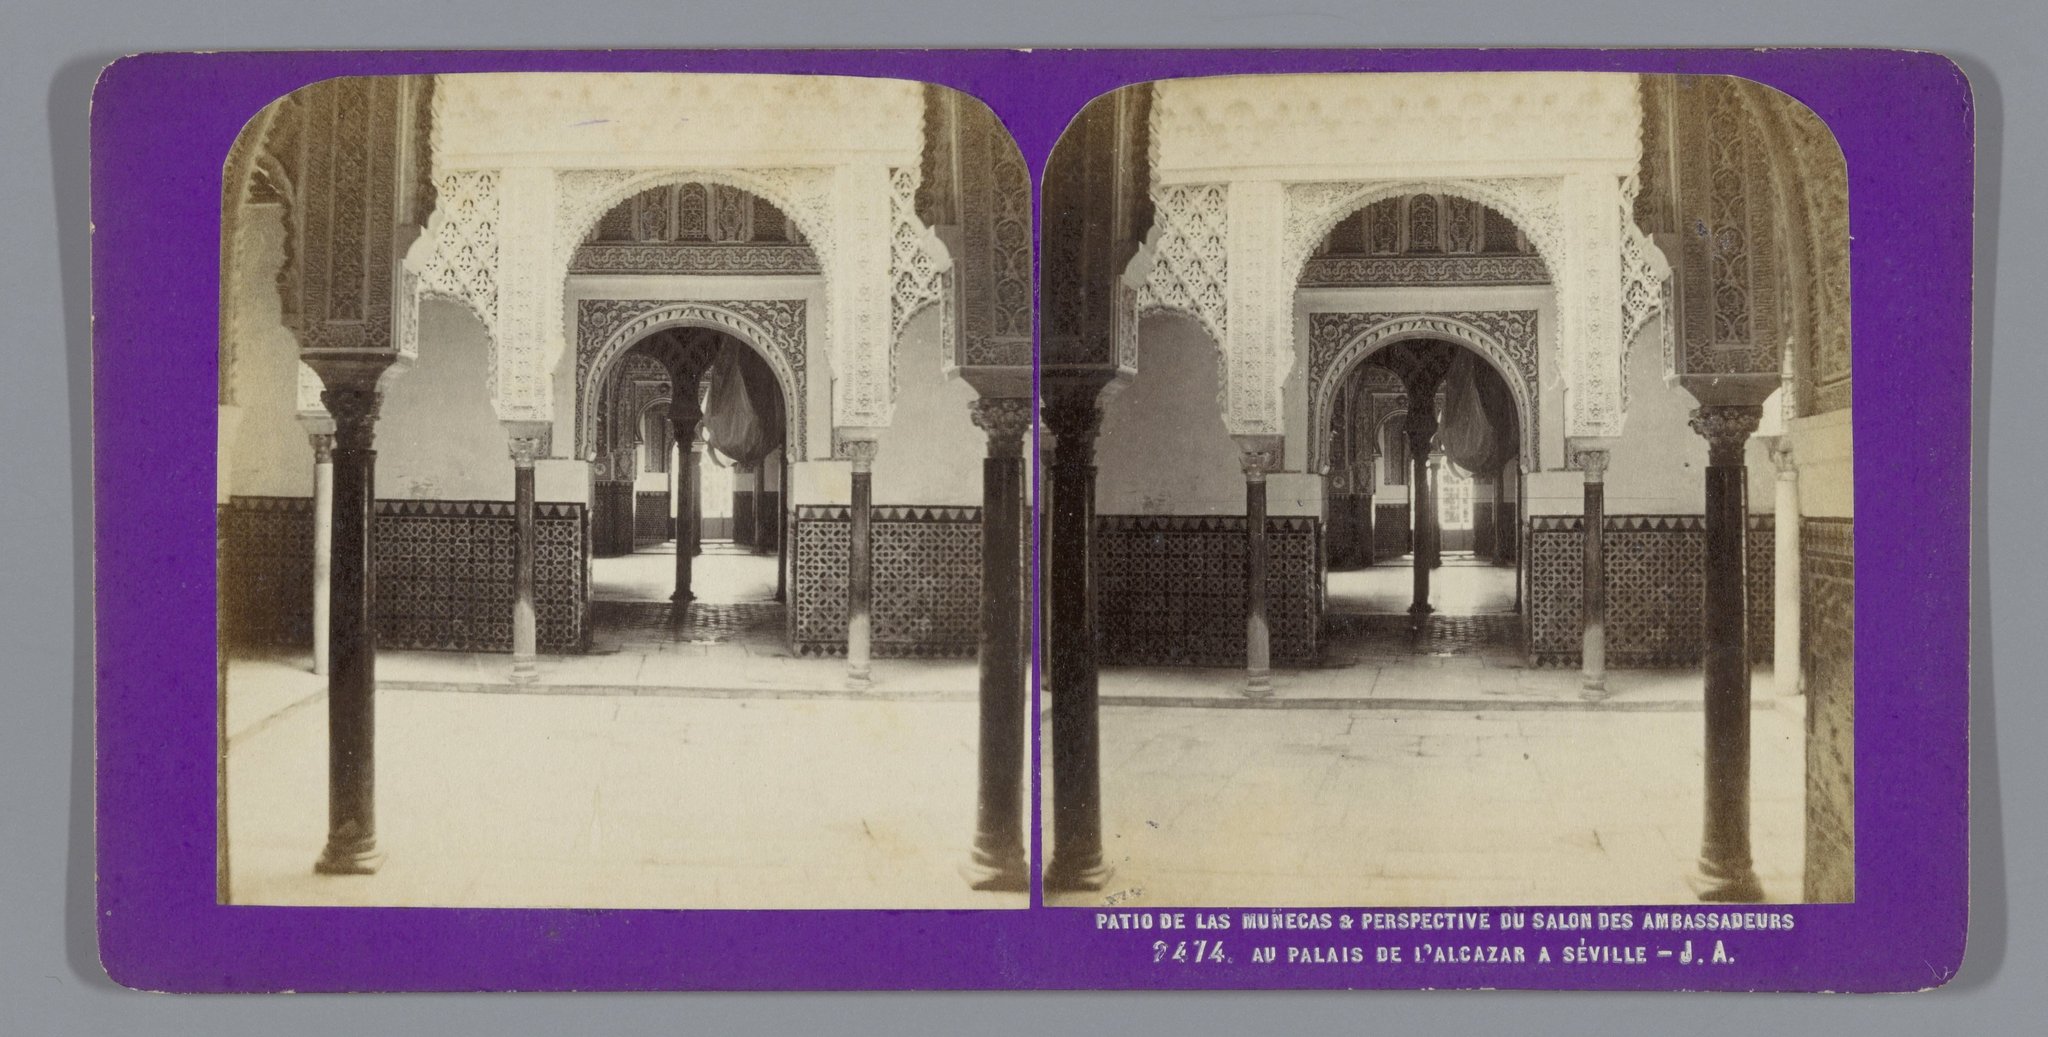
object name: stereograph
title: Gezicht op de Patio de las Muñecas en de Salón de Embajadores in het Alcazar in Sevilla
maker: jean andrieu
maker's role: fotograaf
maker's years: 1816-1872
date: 1862-1876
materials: cardboard, photographic support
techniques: albumen print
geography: royal palace of seville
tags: arch, archivolt ~ architecture, courtyard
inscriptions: number: ‘2474.’